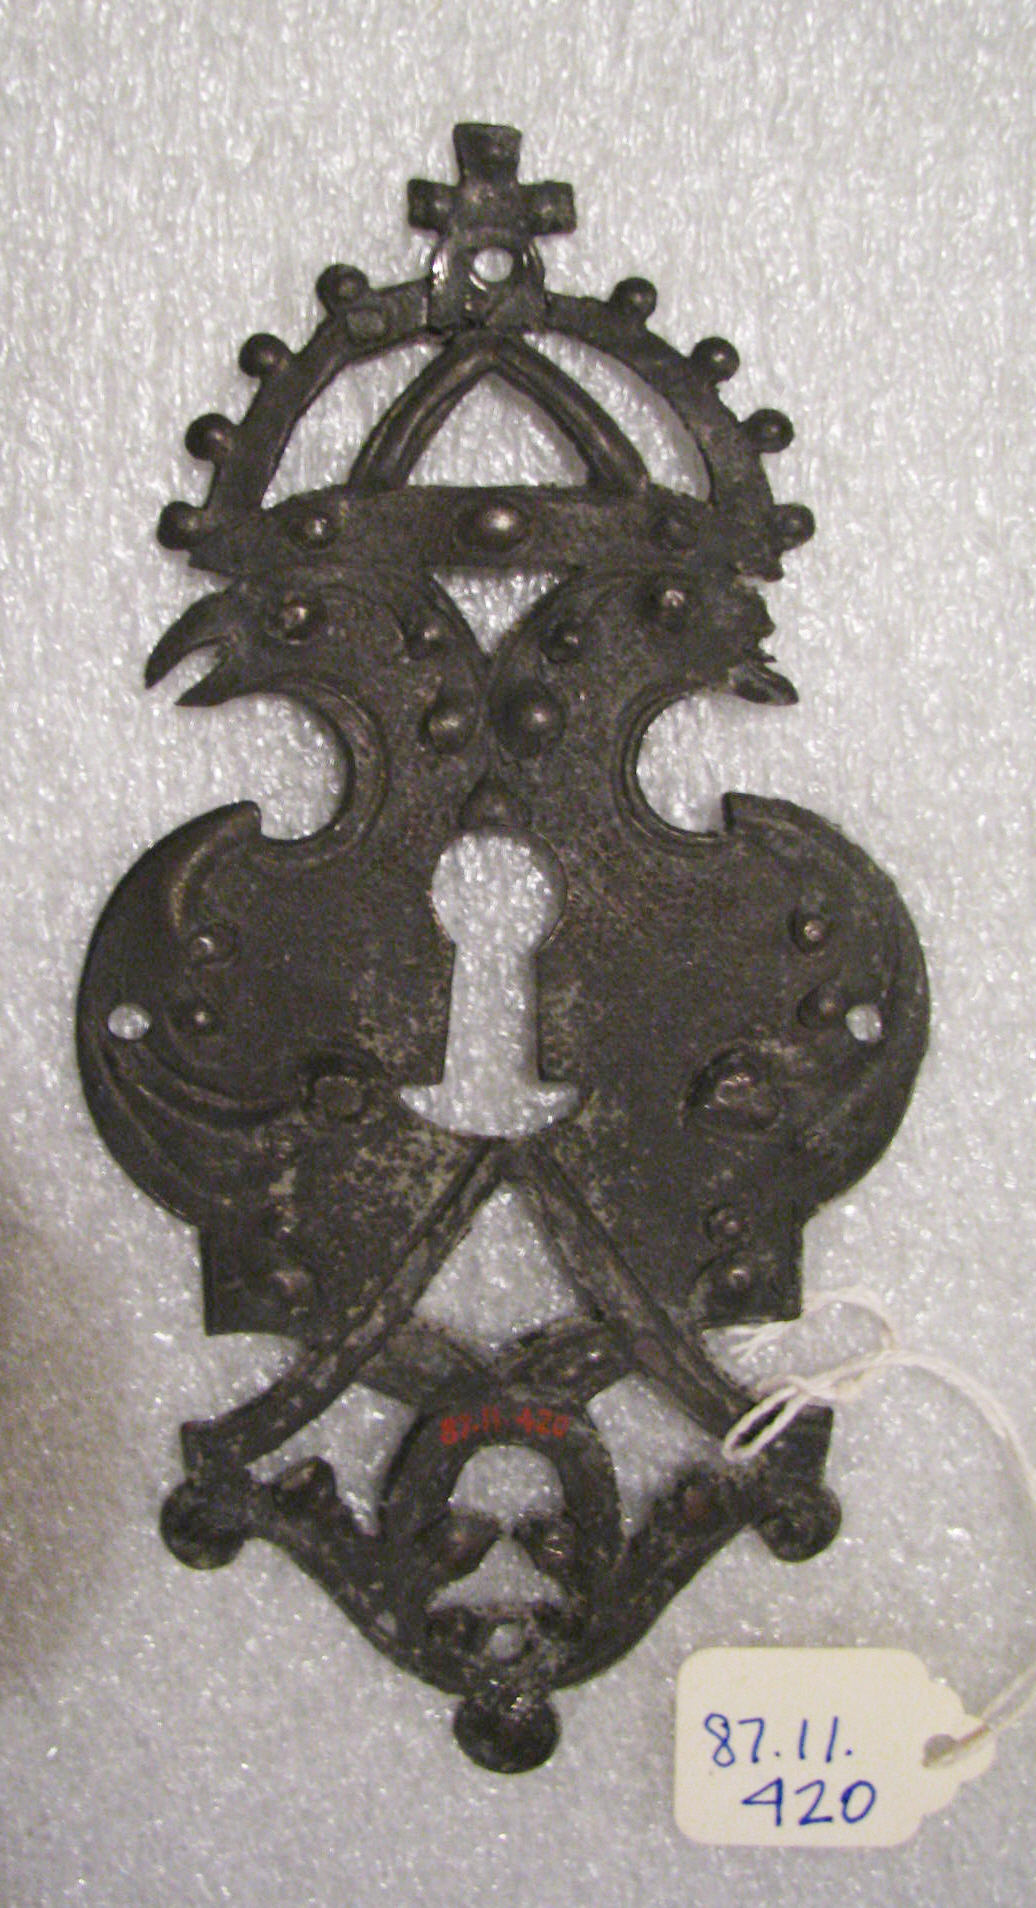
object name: escutcheon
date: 1601-1650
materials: iron